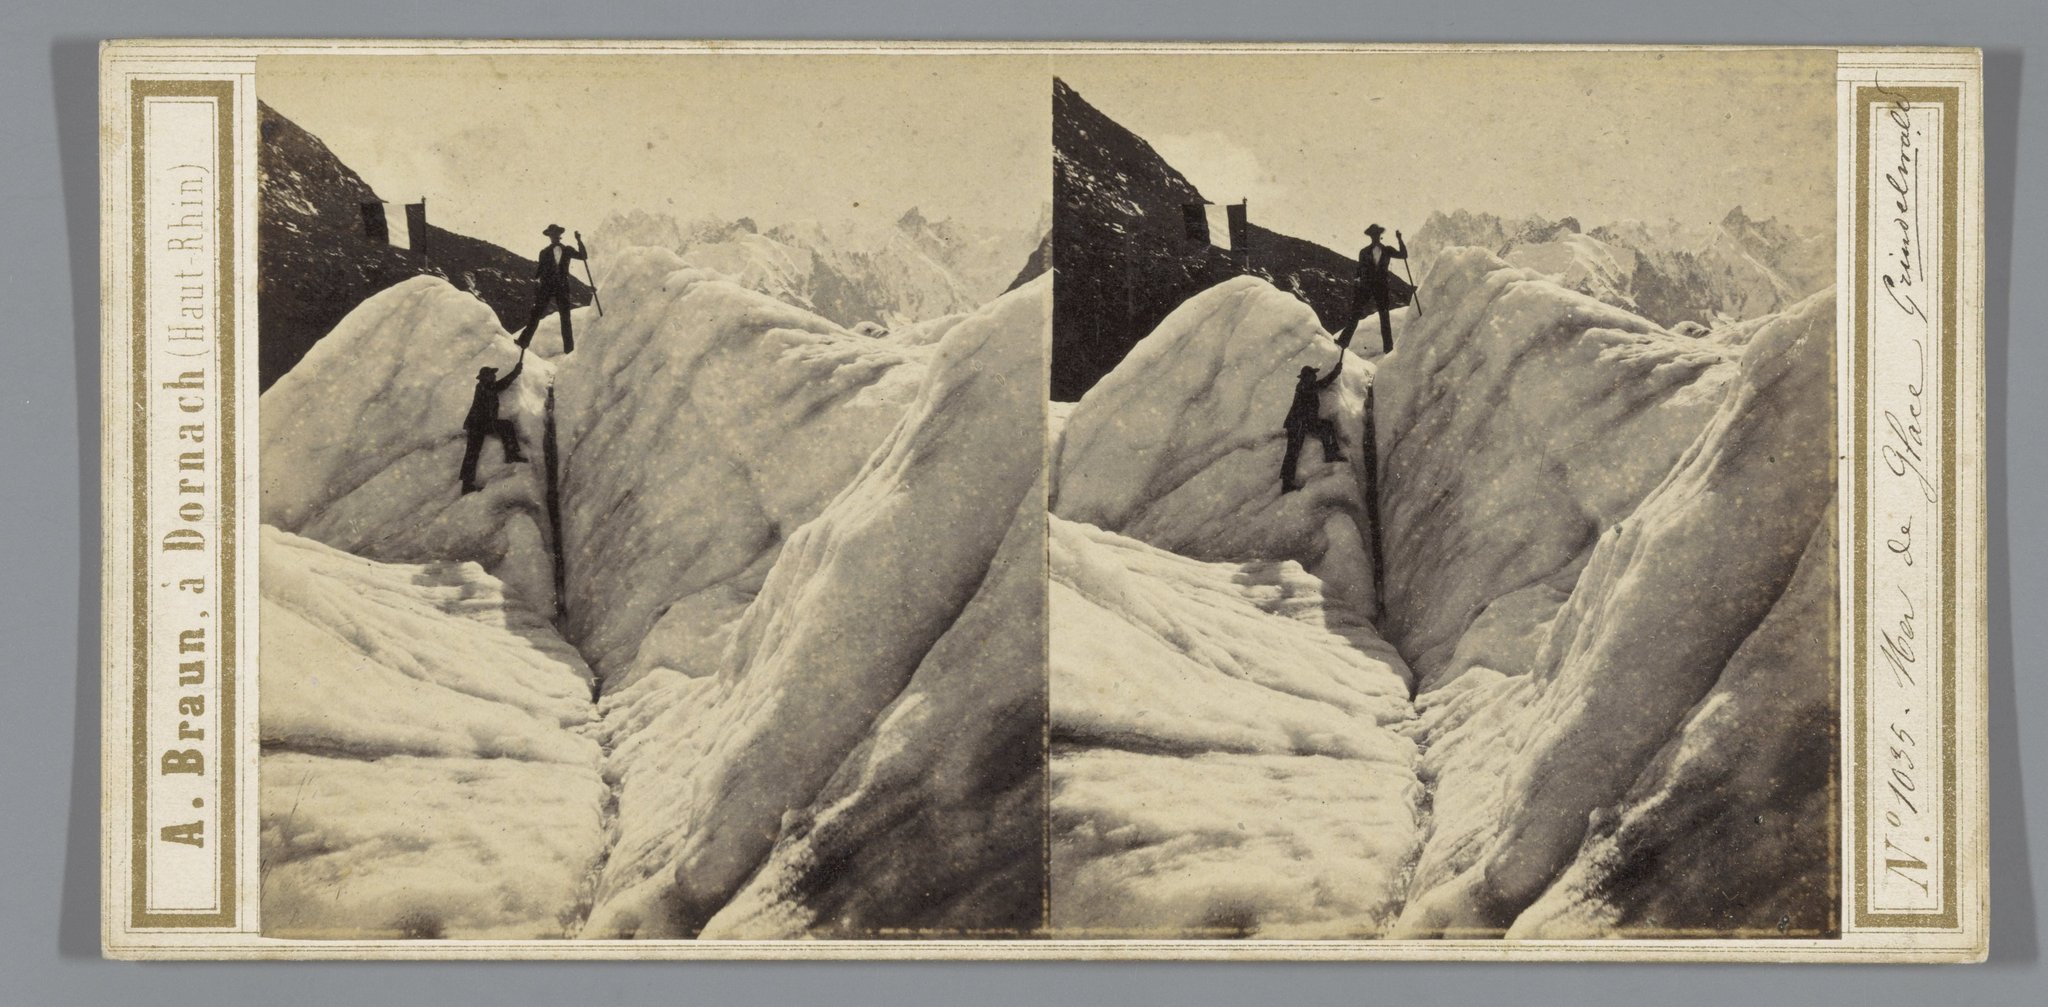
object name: stereograph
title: Mer de Glace Grindelwald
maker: Anonymous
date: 1860-1866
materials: cardboard, paper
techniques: albumen print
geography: mer de glace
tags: flag display, glacier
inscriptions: number: ‘No. 1035.’, number: ‘100’, number: ‘9a’, inscription: ‘Suisse/ Juli 1867 - Aug 1885’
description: Titel op object incorrect. De Mer de Glace bevindt zich aan de noordzijde van de Mont Blanc in Chamonix, Frankrijk. Niet in of nabij Grindelwald, Zwitserland.